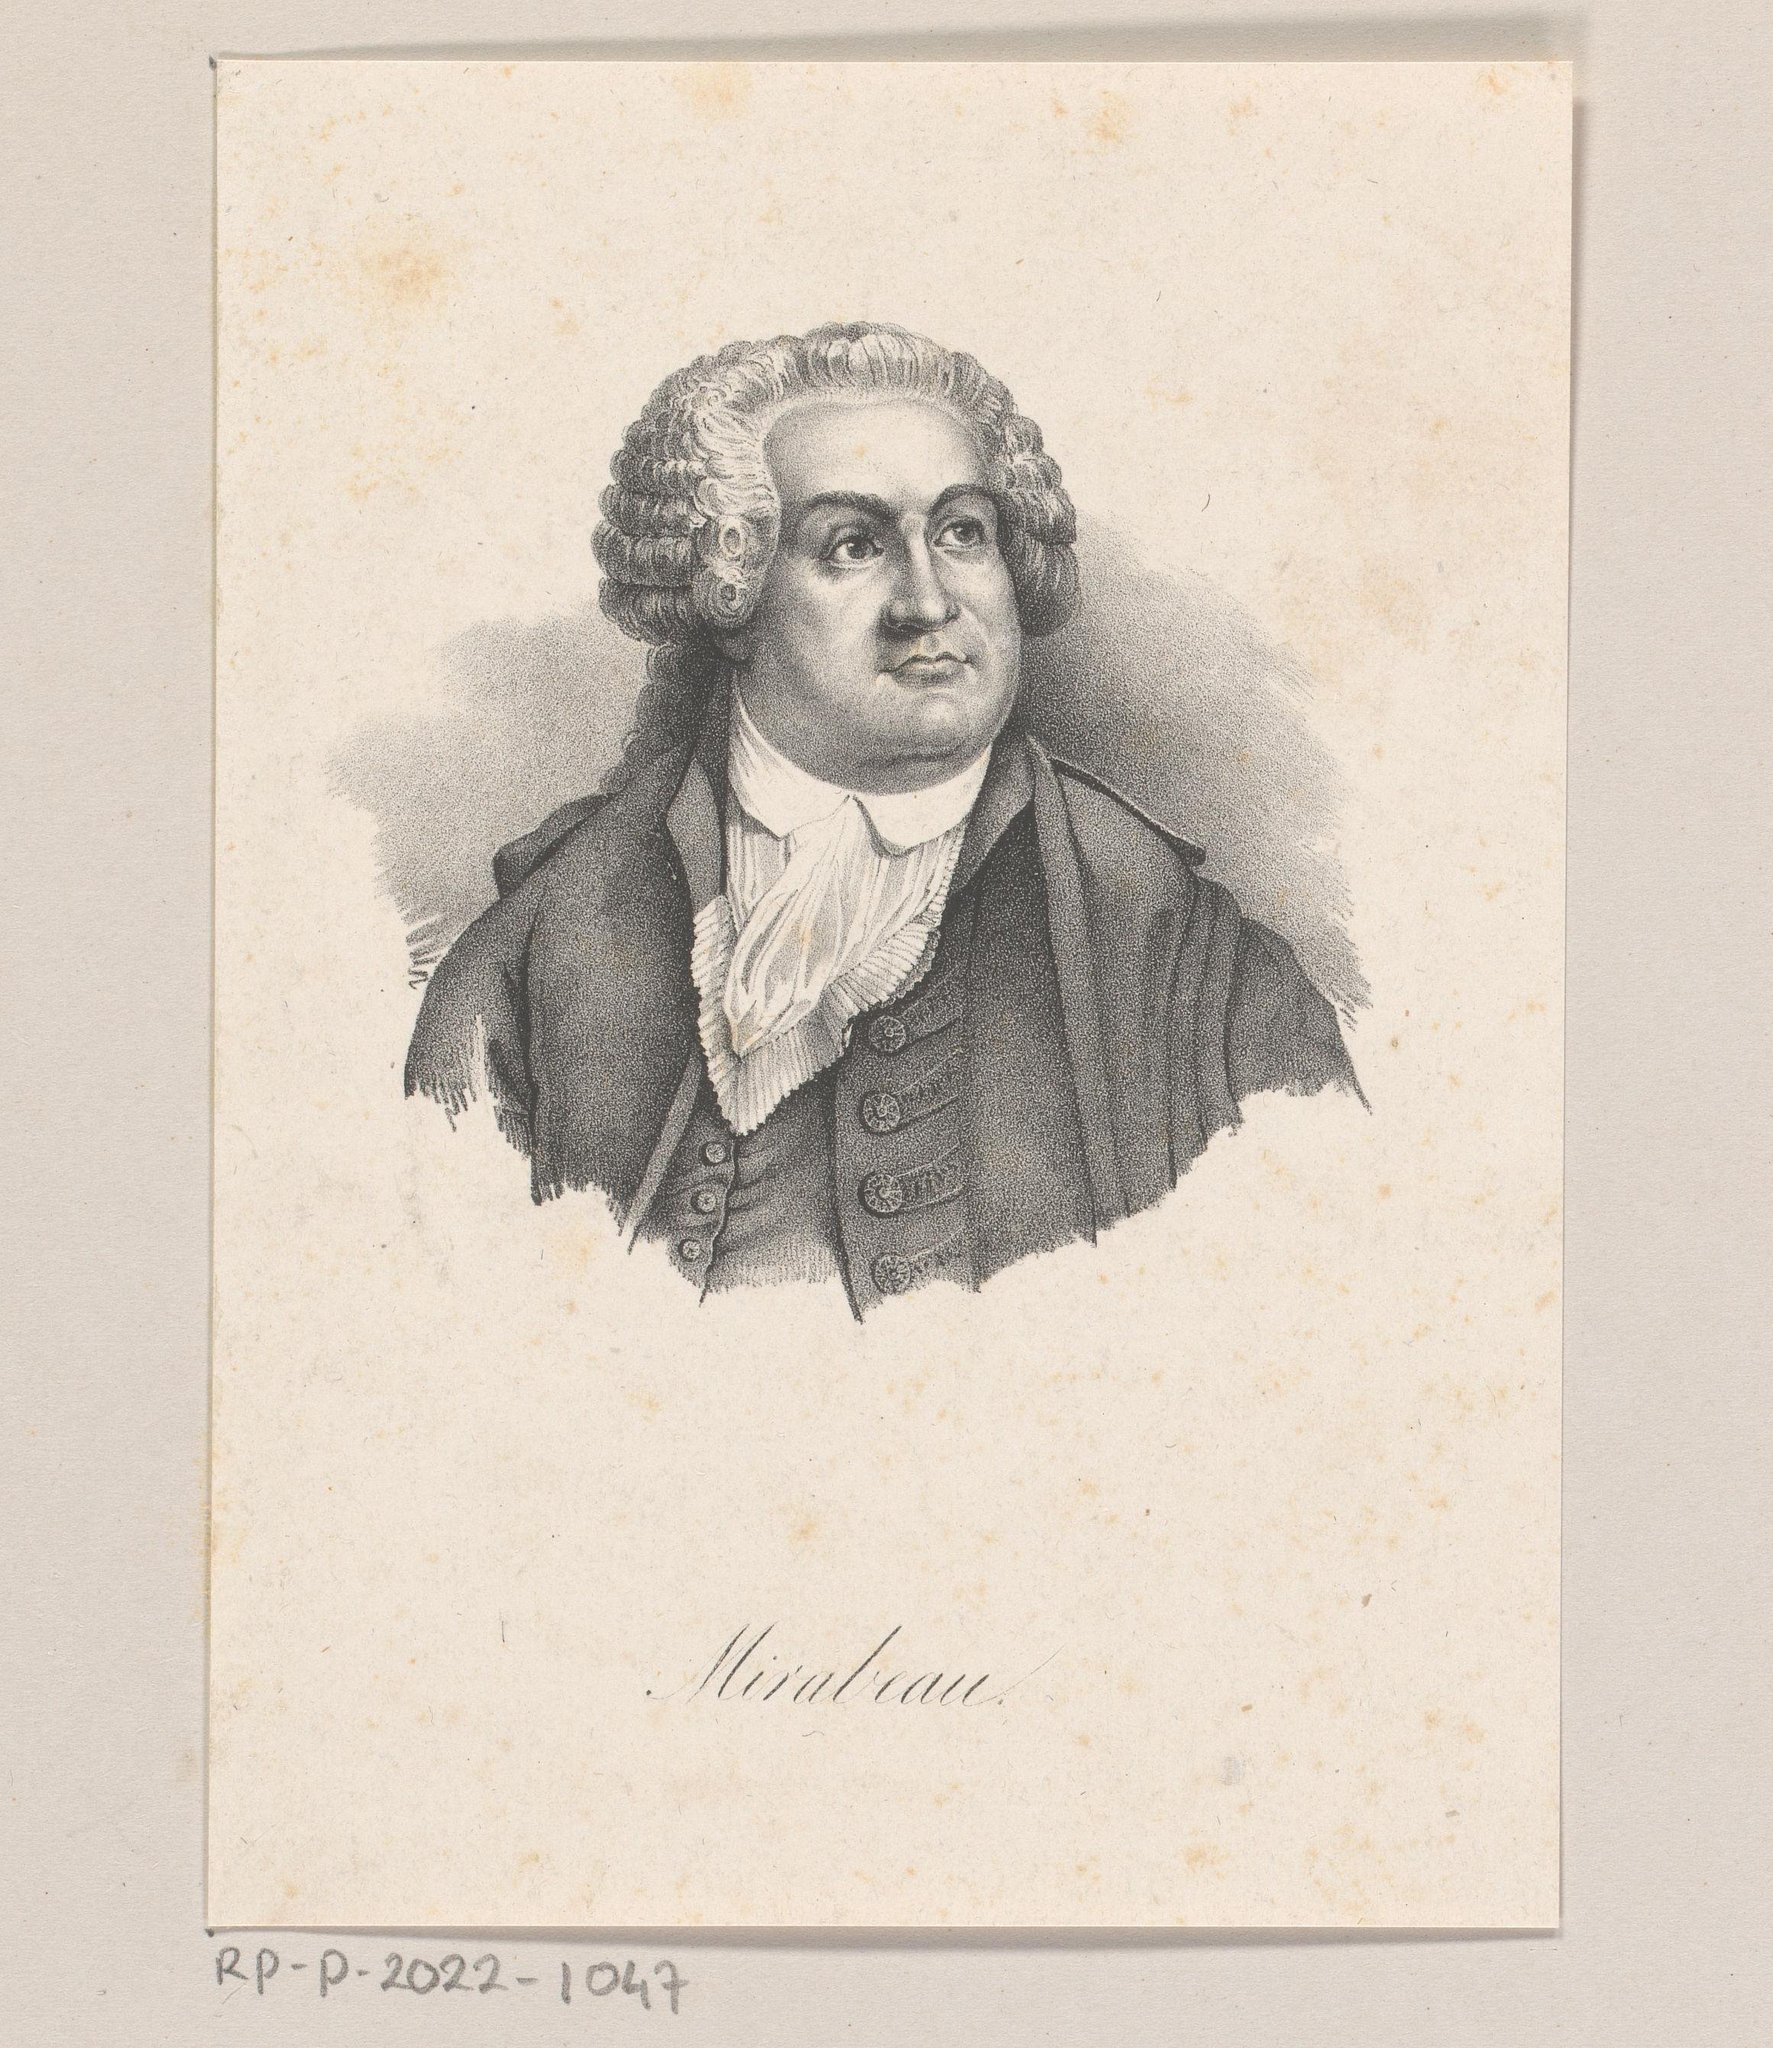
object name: print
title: Mirabeau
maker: Anonymous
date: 1800-1900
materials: paper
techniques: lithograph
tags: paris, politician, honoré-gabriel de riqueti (graaf van mirabeau), historical persons, ambassador